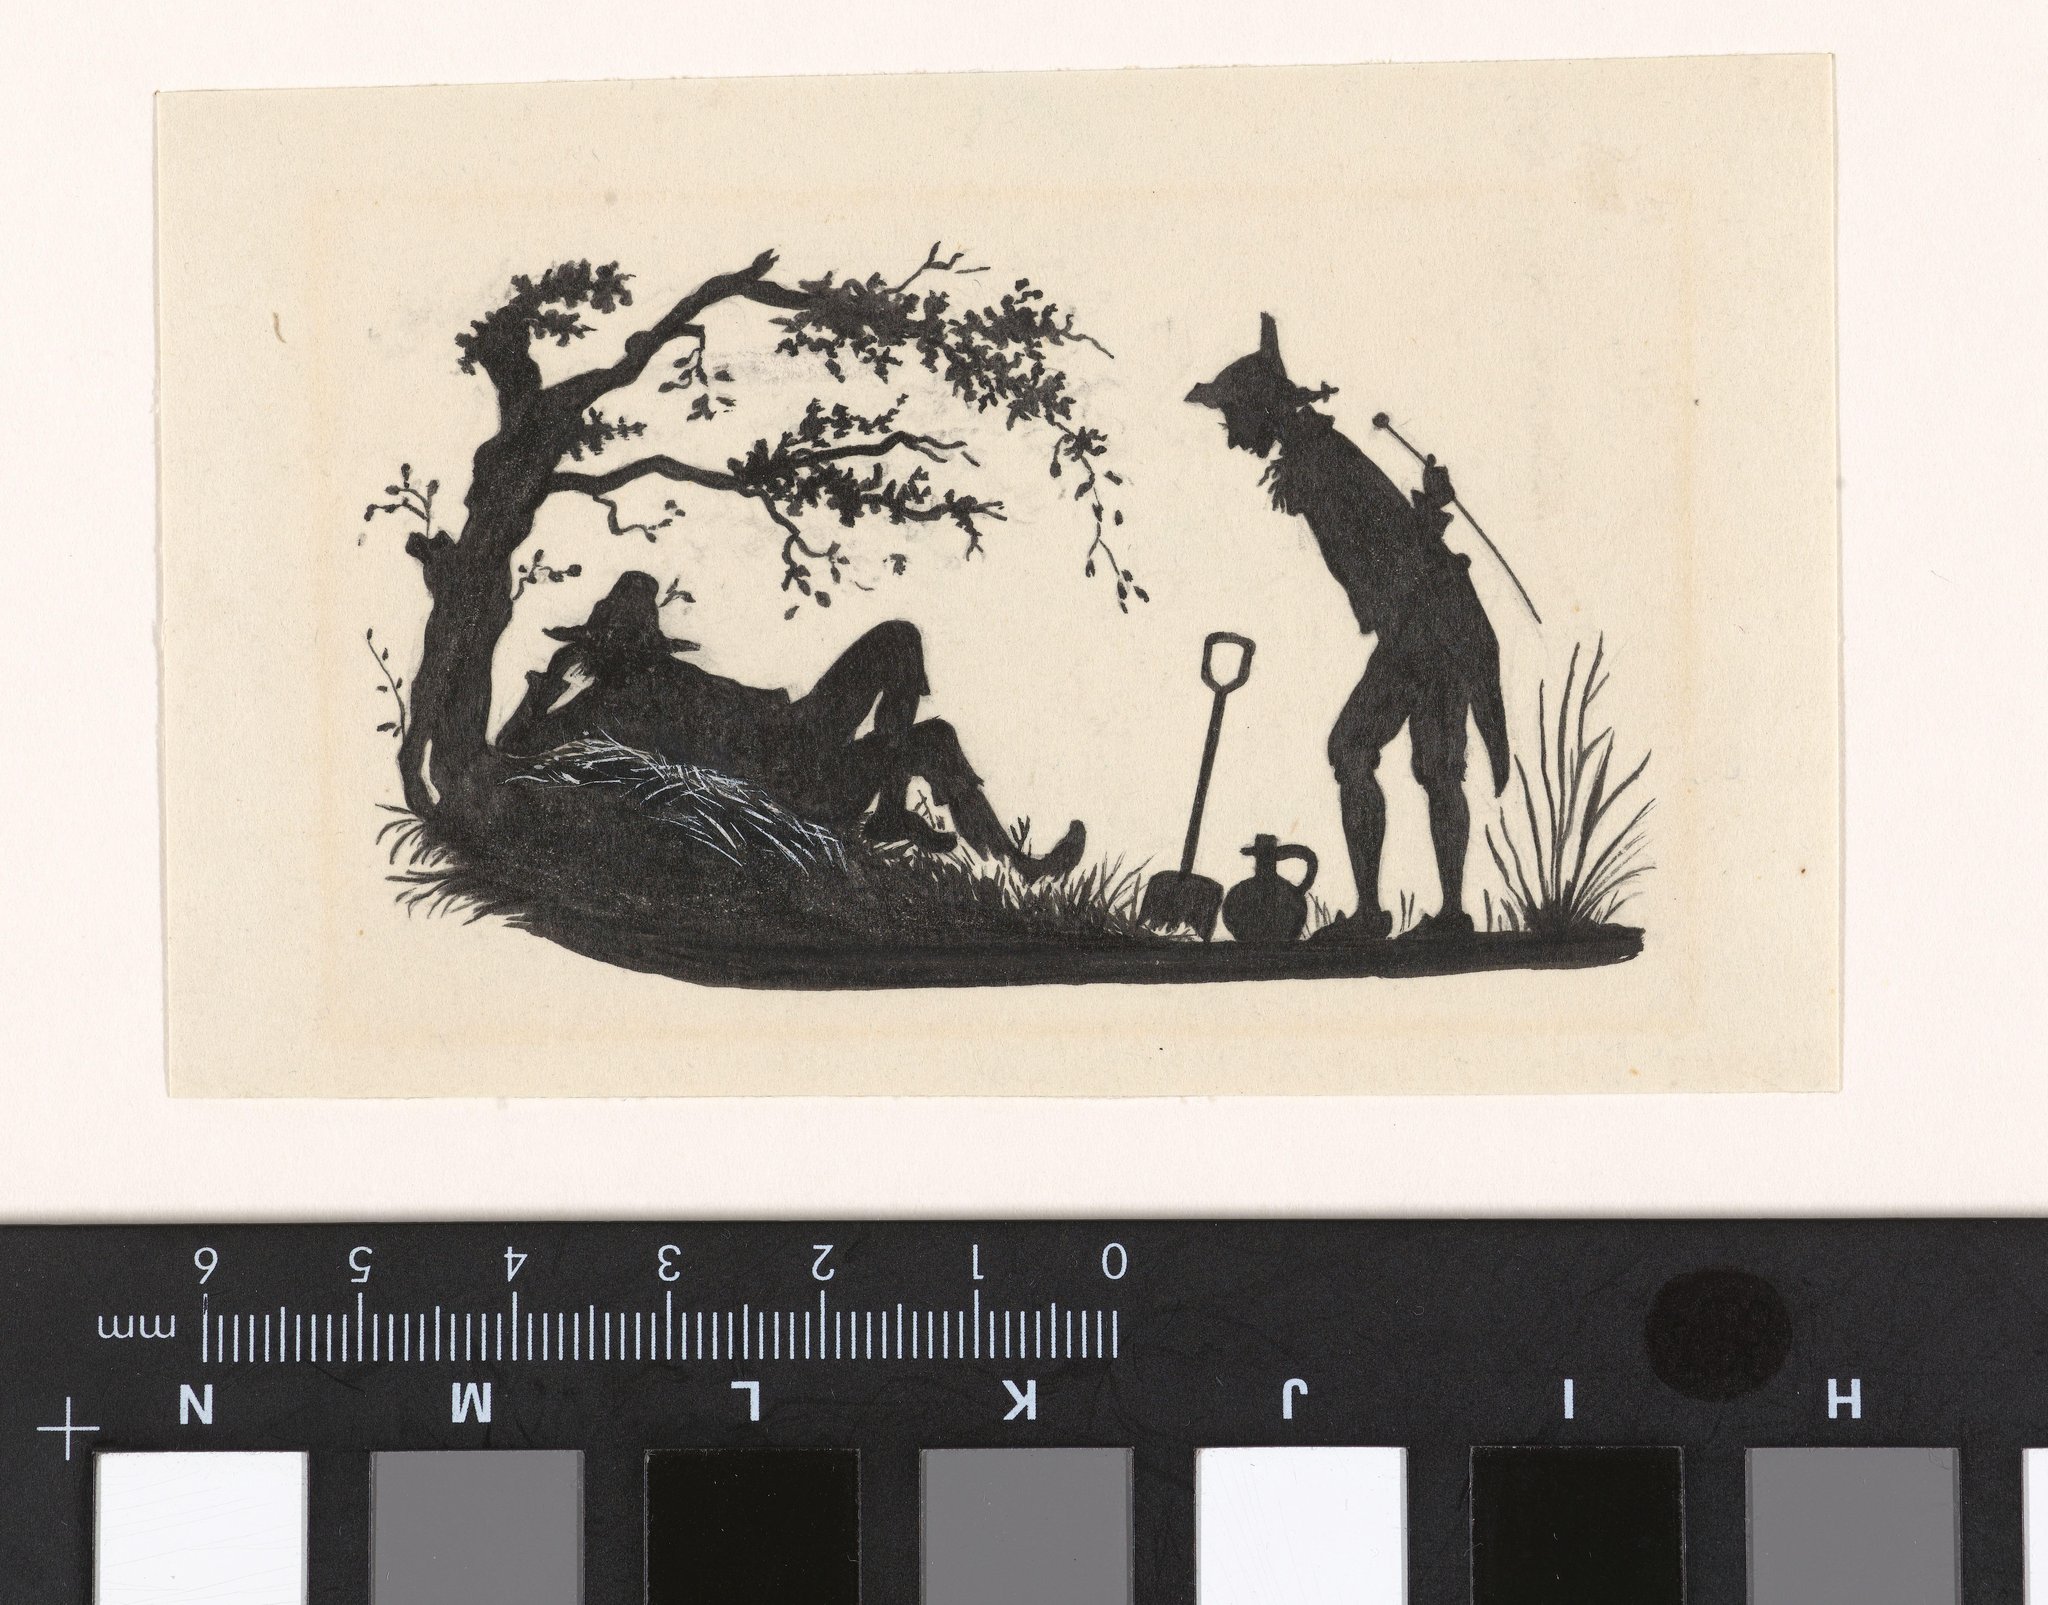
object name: drawing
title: Ontwerp voor illustratie voor In Holland staat een huis: silhouet van de man die de knecht betrapt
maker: nelly bodenheim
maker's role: designer, draughtsman, print maker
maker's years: 1874-1951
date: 1884-1917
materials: paint, paper, pencil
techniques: brush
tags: 83(van looy, in holland staat een huis)